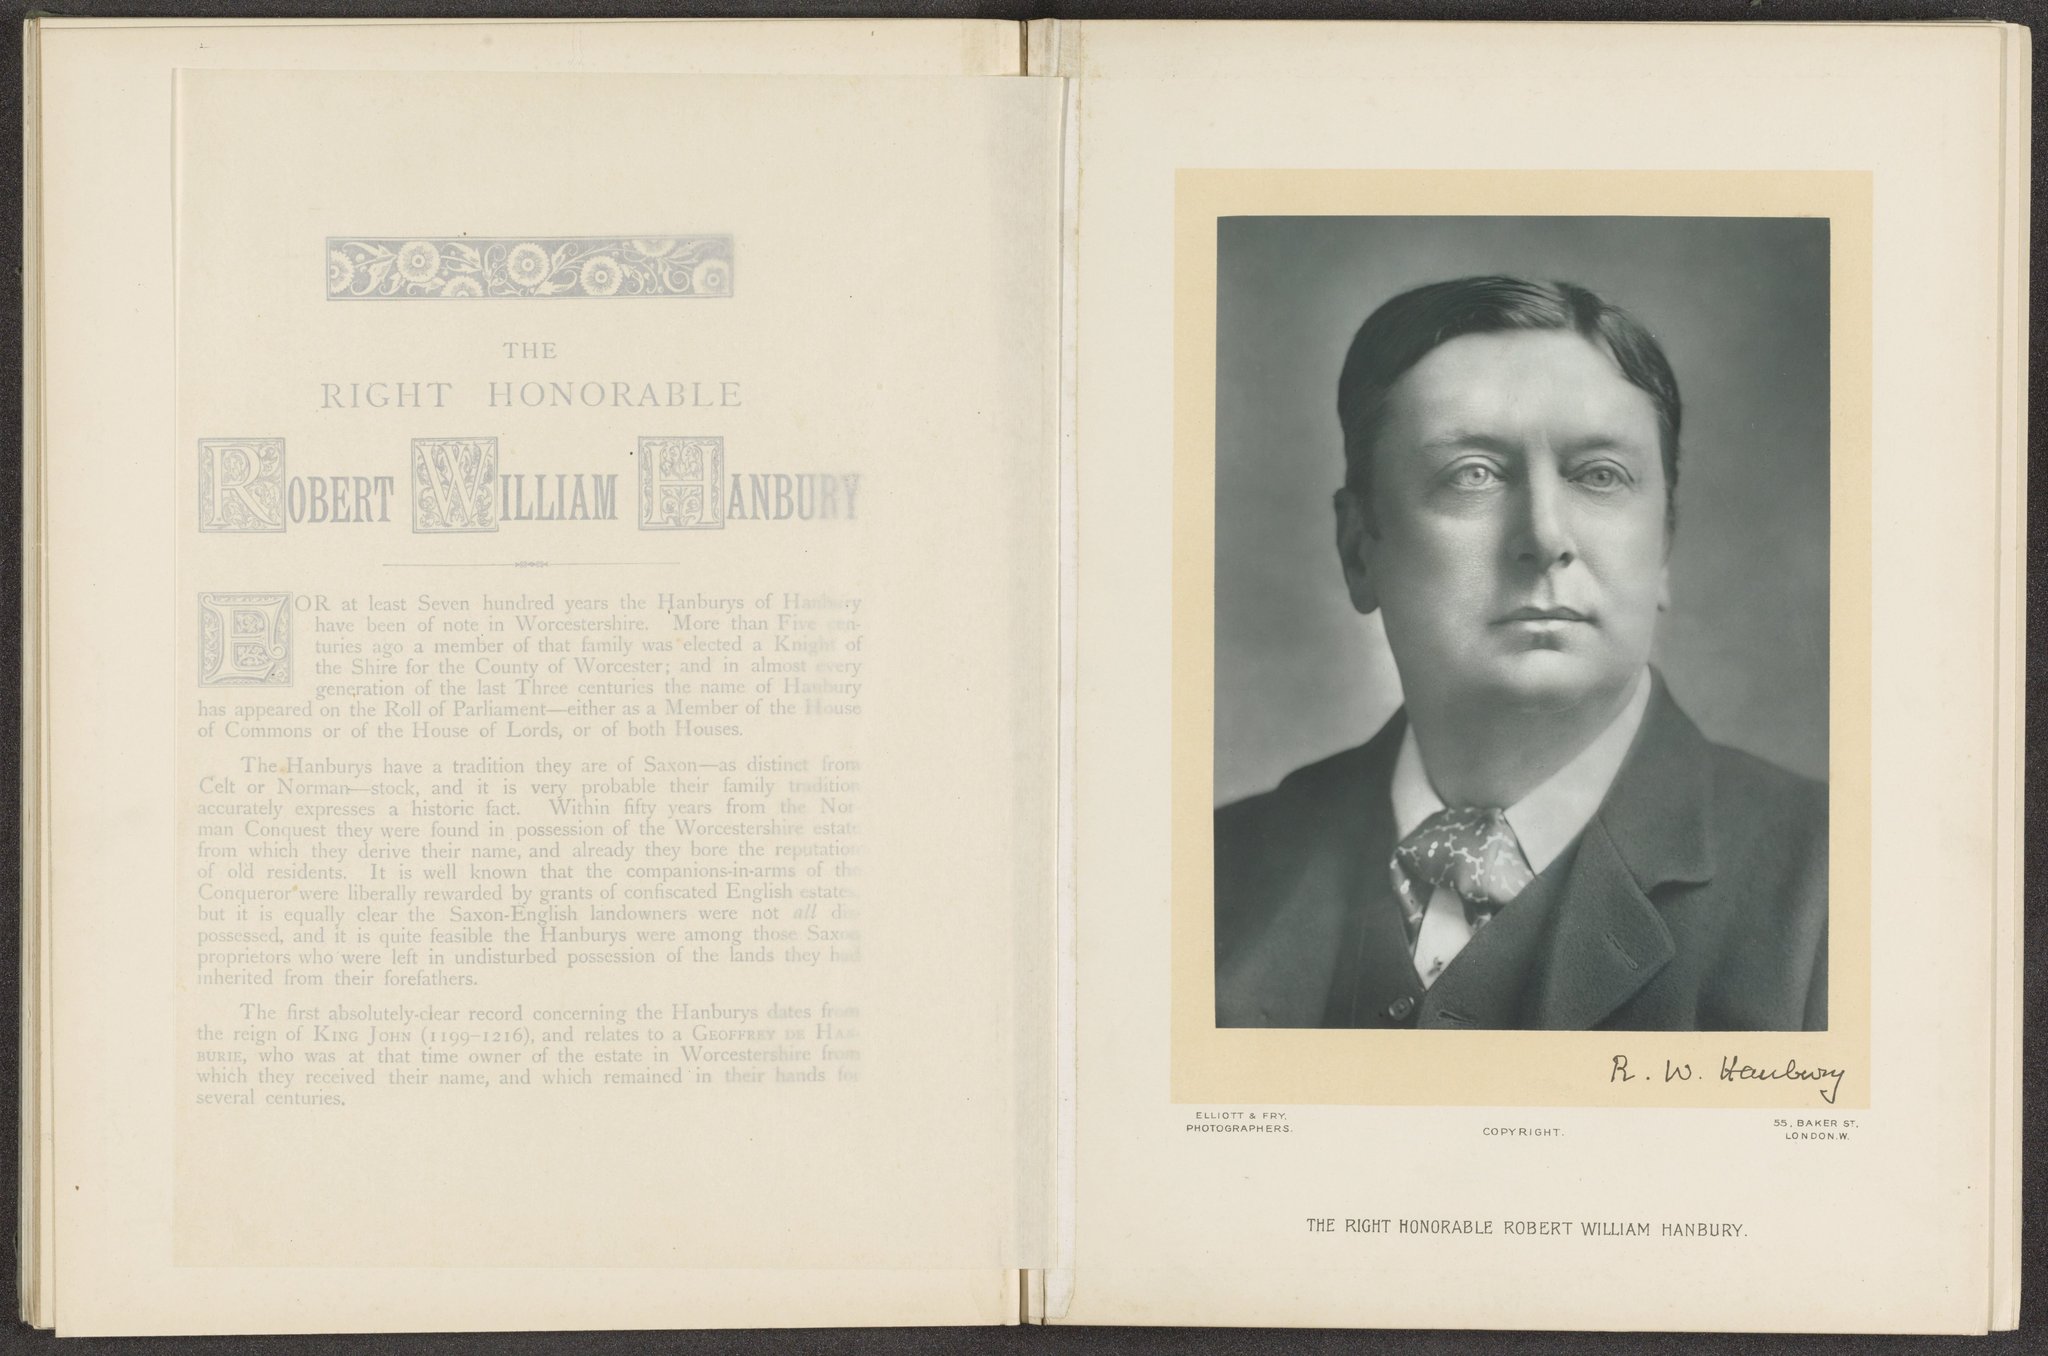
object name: page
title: The right honorable Robert William Hanbury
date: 1893-1903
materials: paper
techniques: carbon print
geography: london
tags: politician, historical persons (portraits and scenes from the life) (+ (full) bust portrait)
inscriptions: annotation, inscription: ‘55, Baker St, London, W.’